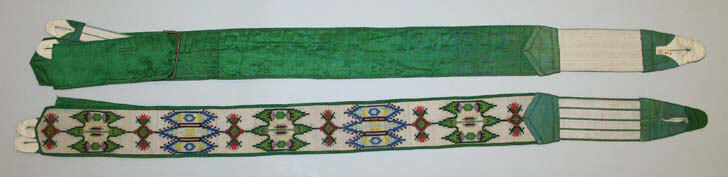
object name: suspender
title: Suspenders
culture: european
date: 1801-1833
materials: cotton, silk